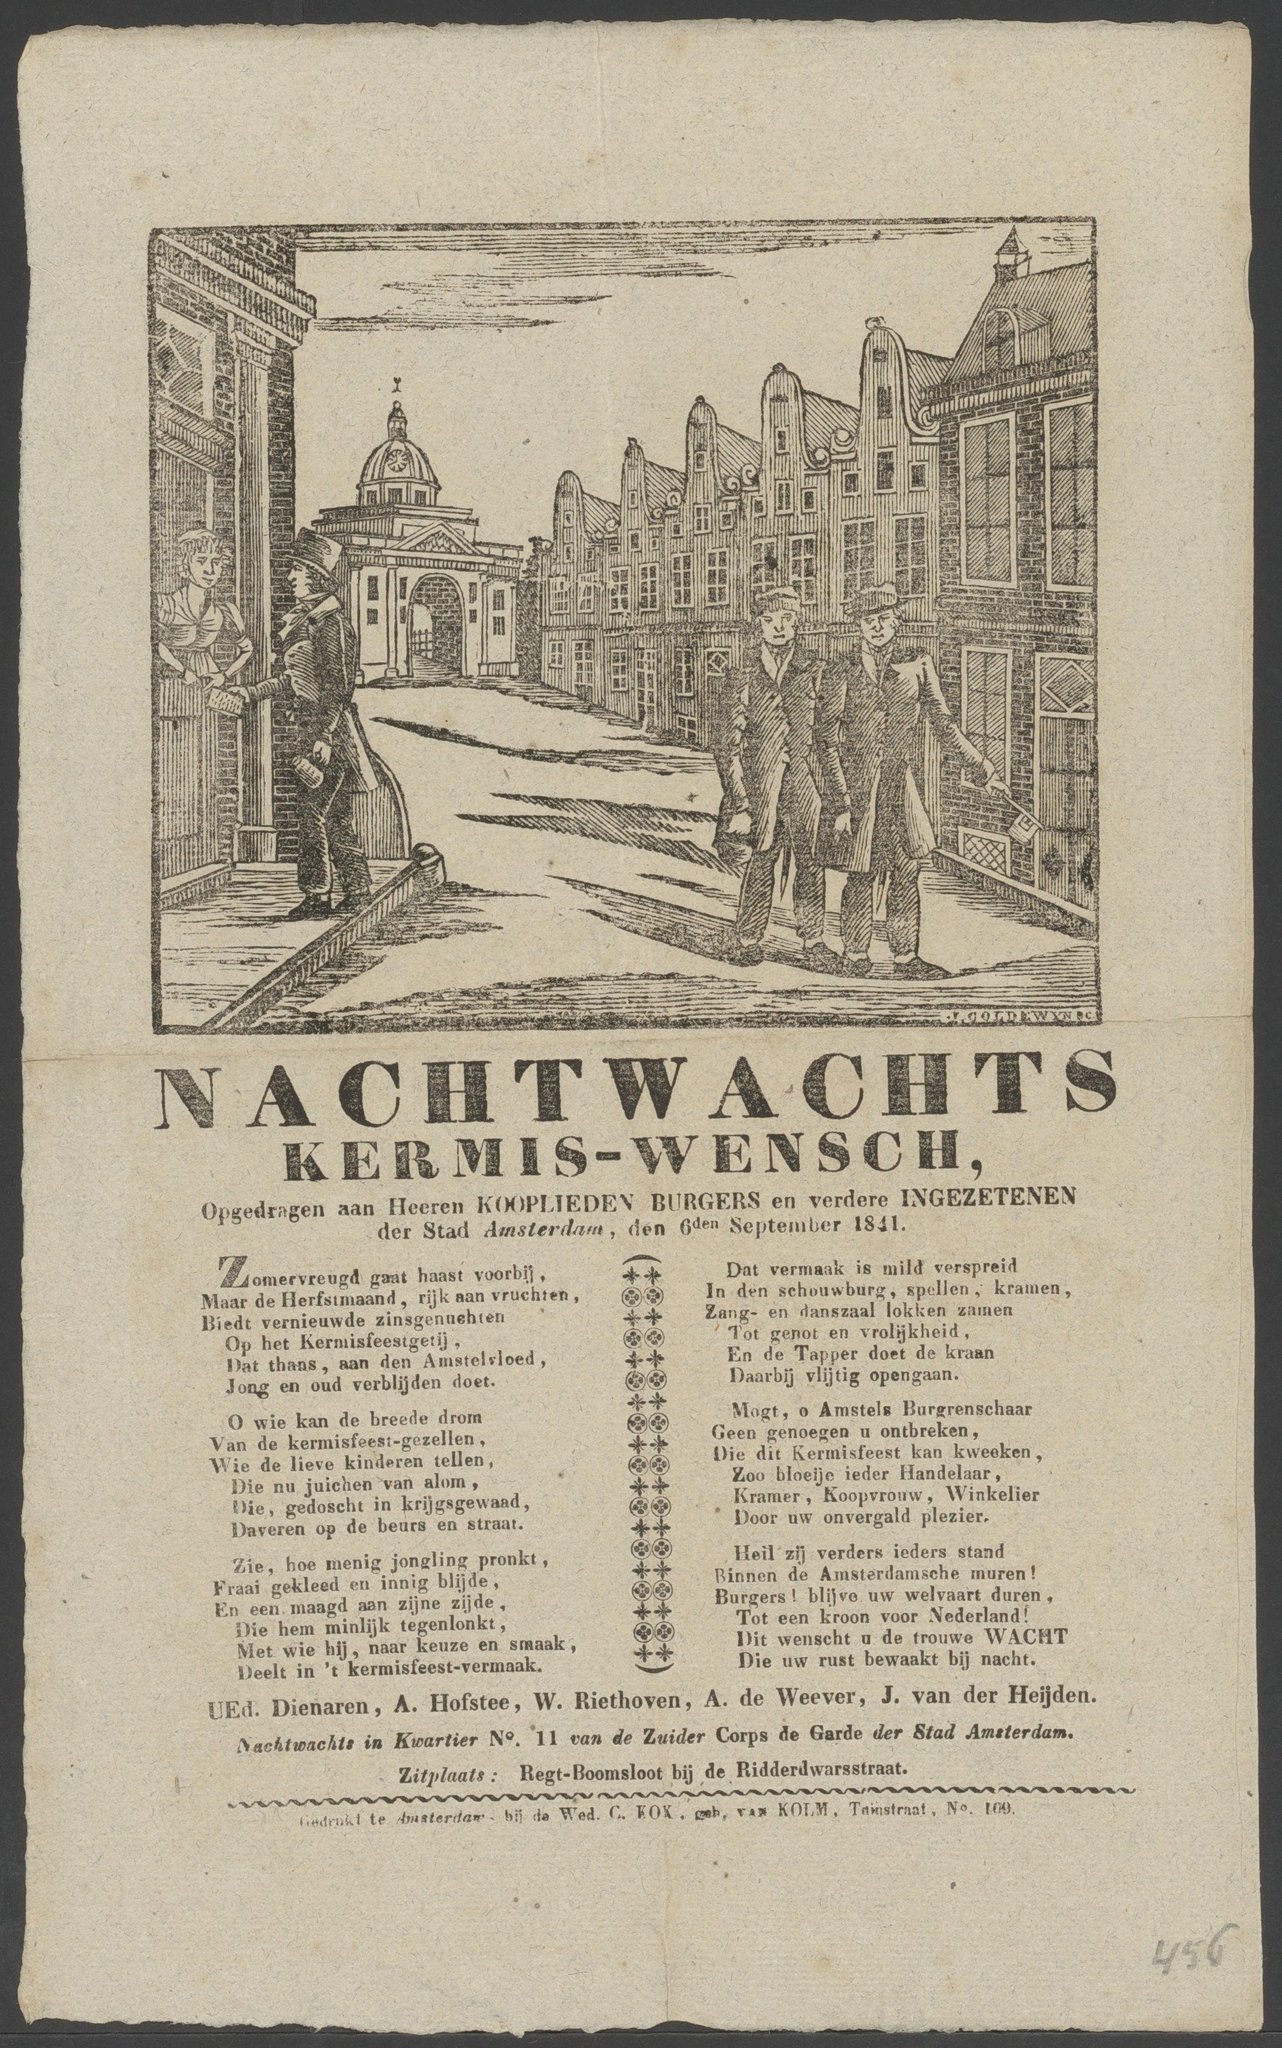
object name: print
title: Nachtwachts Kermis-wensch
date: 1841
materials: paper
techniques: letterpress printing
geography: amsterdam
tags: night patrol, street, amsterdam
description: Kermisprent van de Amsterdamse nachtwacht (ratelwacht), 6 september 1841. Enkele mannen lopen 's nachts met ratels door een straat. In de verte de oude Muiderpoort. Met een vers in twee kolommen. Namens de nachtwacht in kwartier No. 11 van de Tuin Corps de Garde: A. Hofstee, W. Riethoven, A. de Weever, J. van der Heijden. Onderwerpsrubrieken binnen de Atlas Zeden en Gewoonten: Zeden en gewoonten in engeren zin, Volksleven, Volksbladen, Nieuwjaars- en Kerstwenschen, Amsterdam.